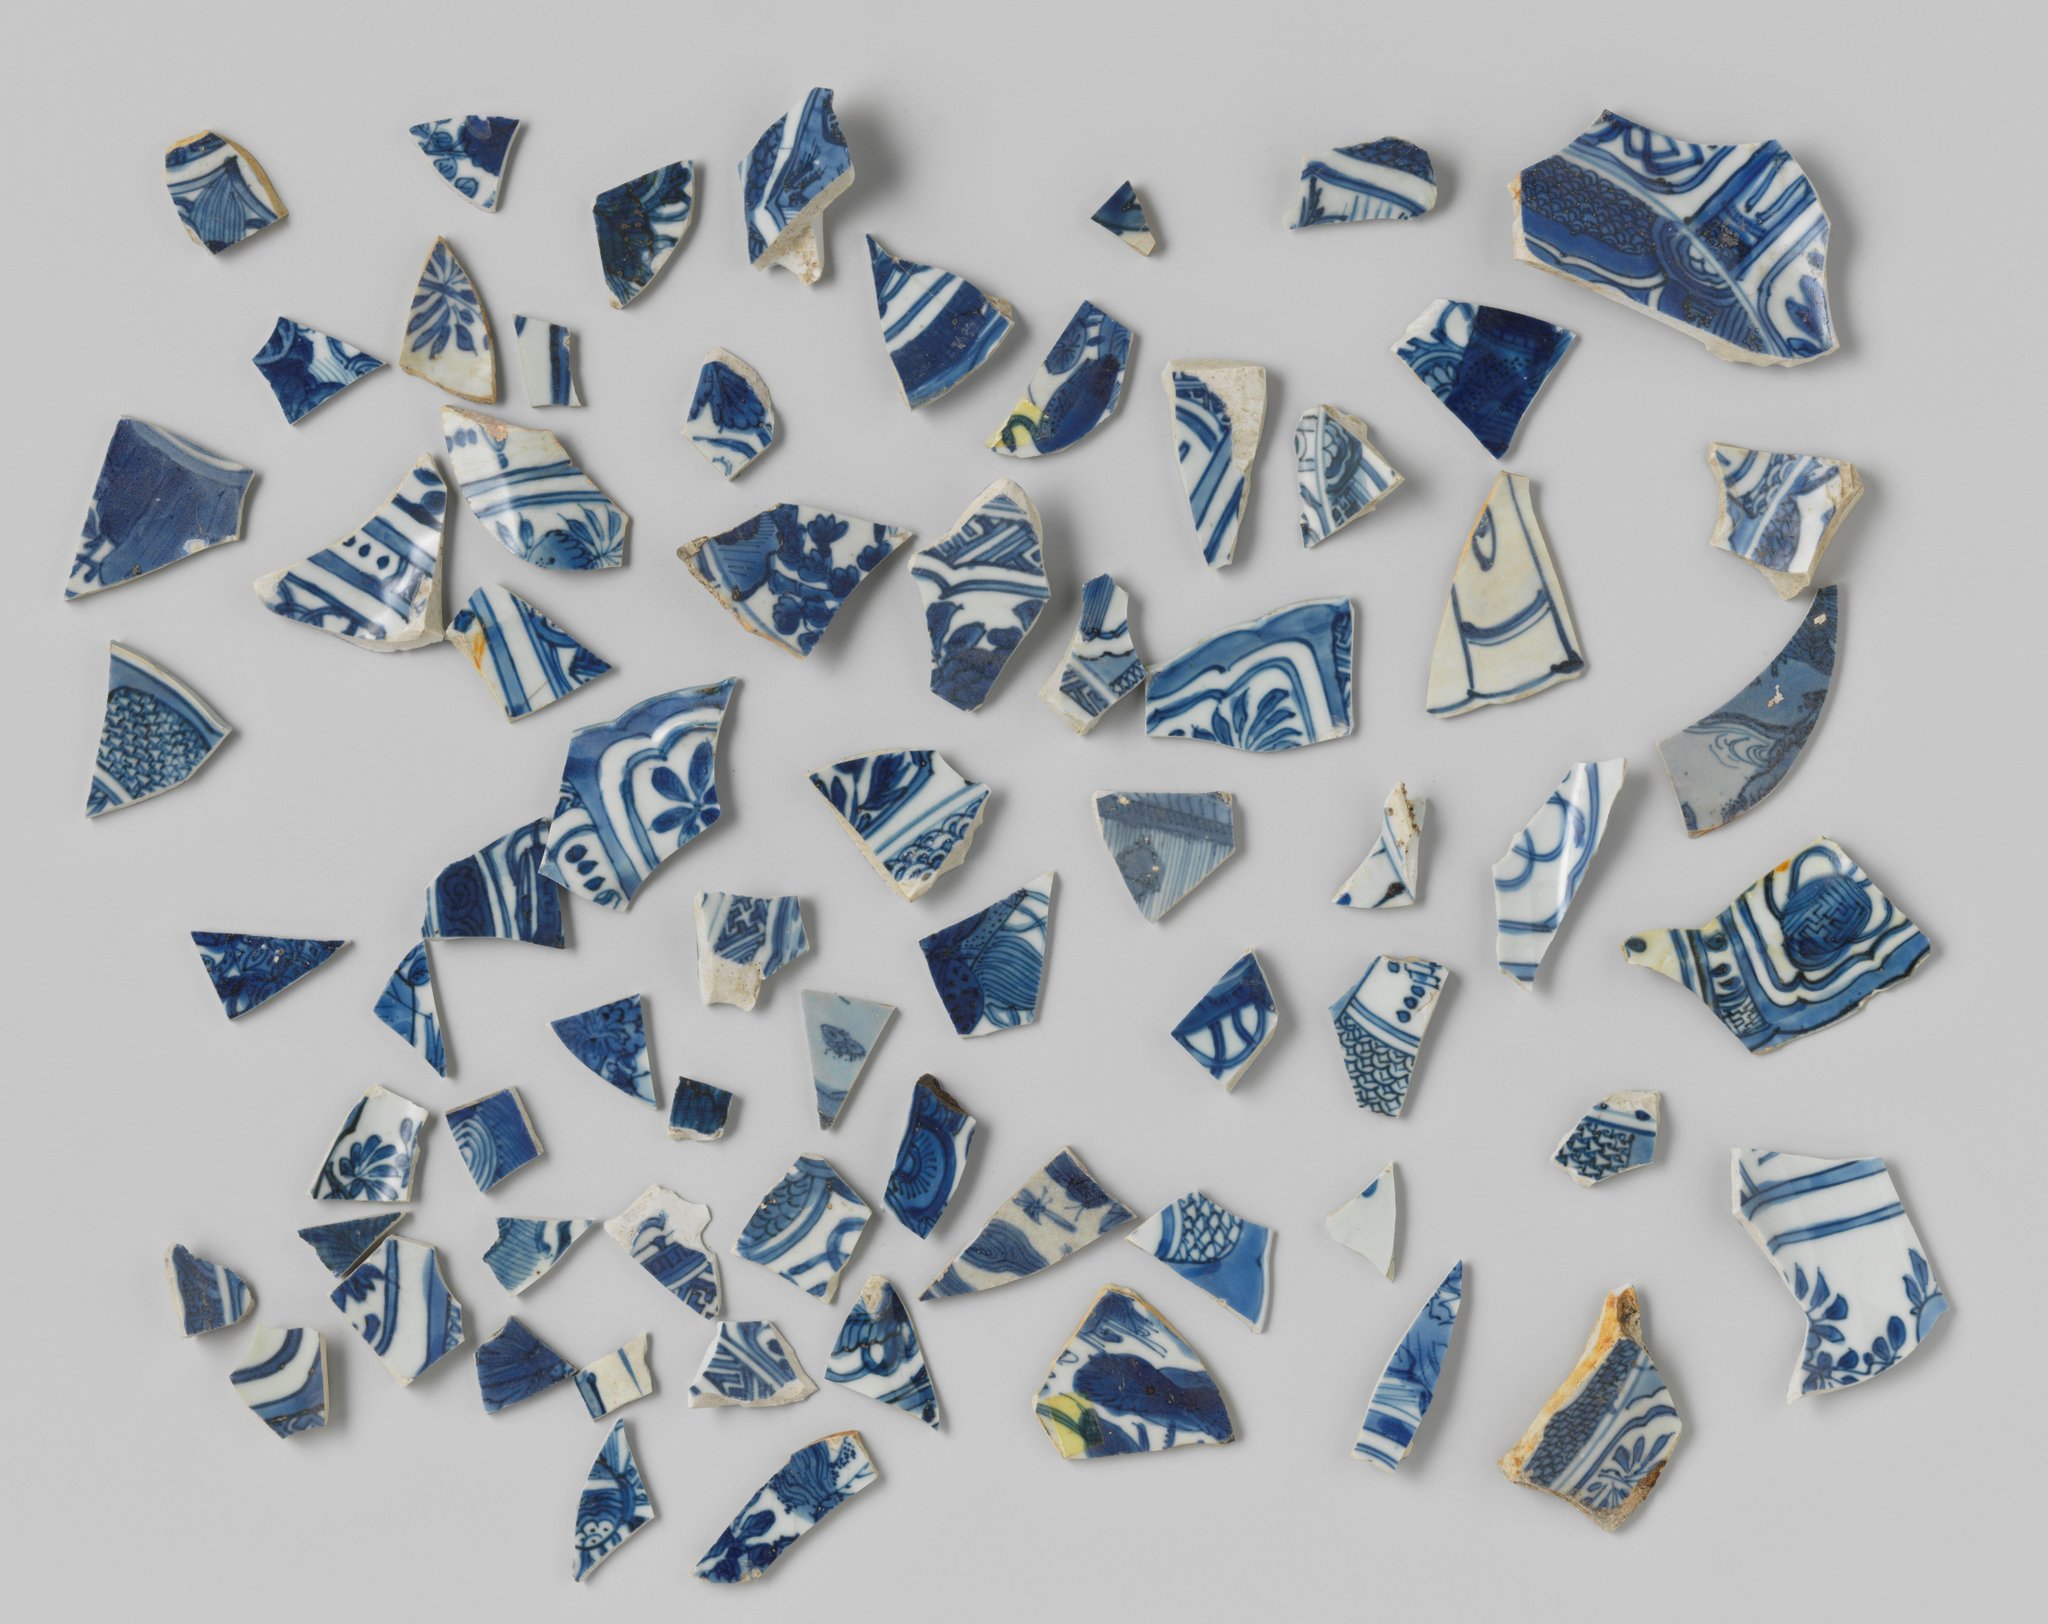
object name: plate dish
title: Scherven van borden uit V.O.C.-schip de 'Witte Leeuw'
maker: Anonymous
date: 1613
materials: bone china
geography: jingdezhen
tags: verenigde oostindische compagnie, sint-helena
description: Scherven van borden uit V.O.C.-schip de 'Witte Leeuw' van kraakporselein.